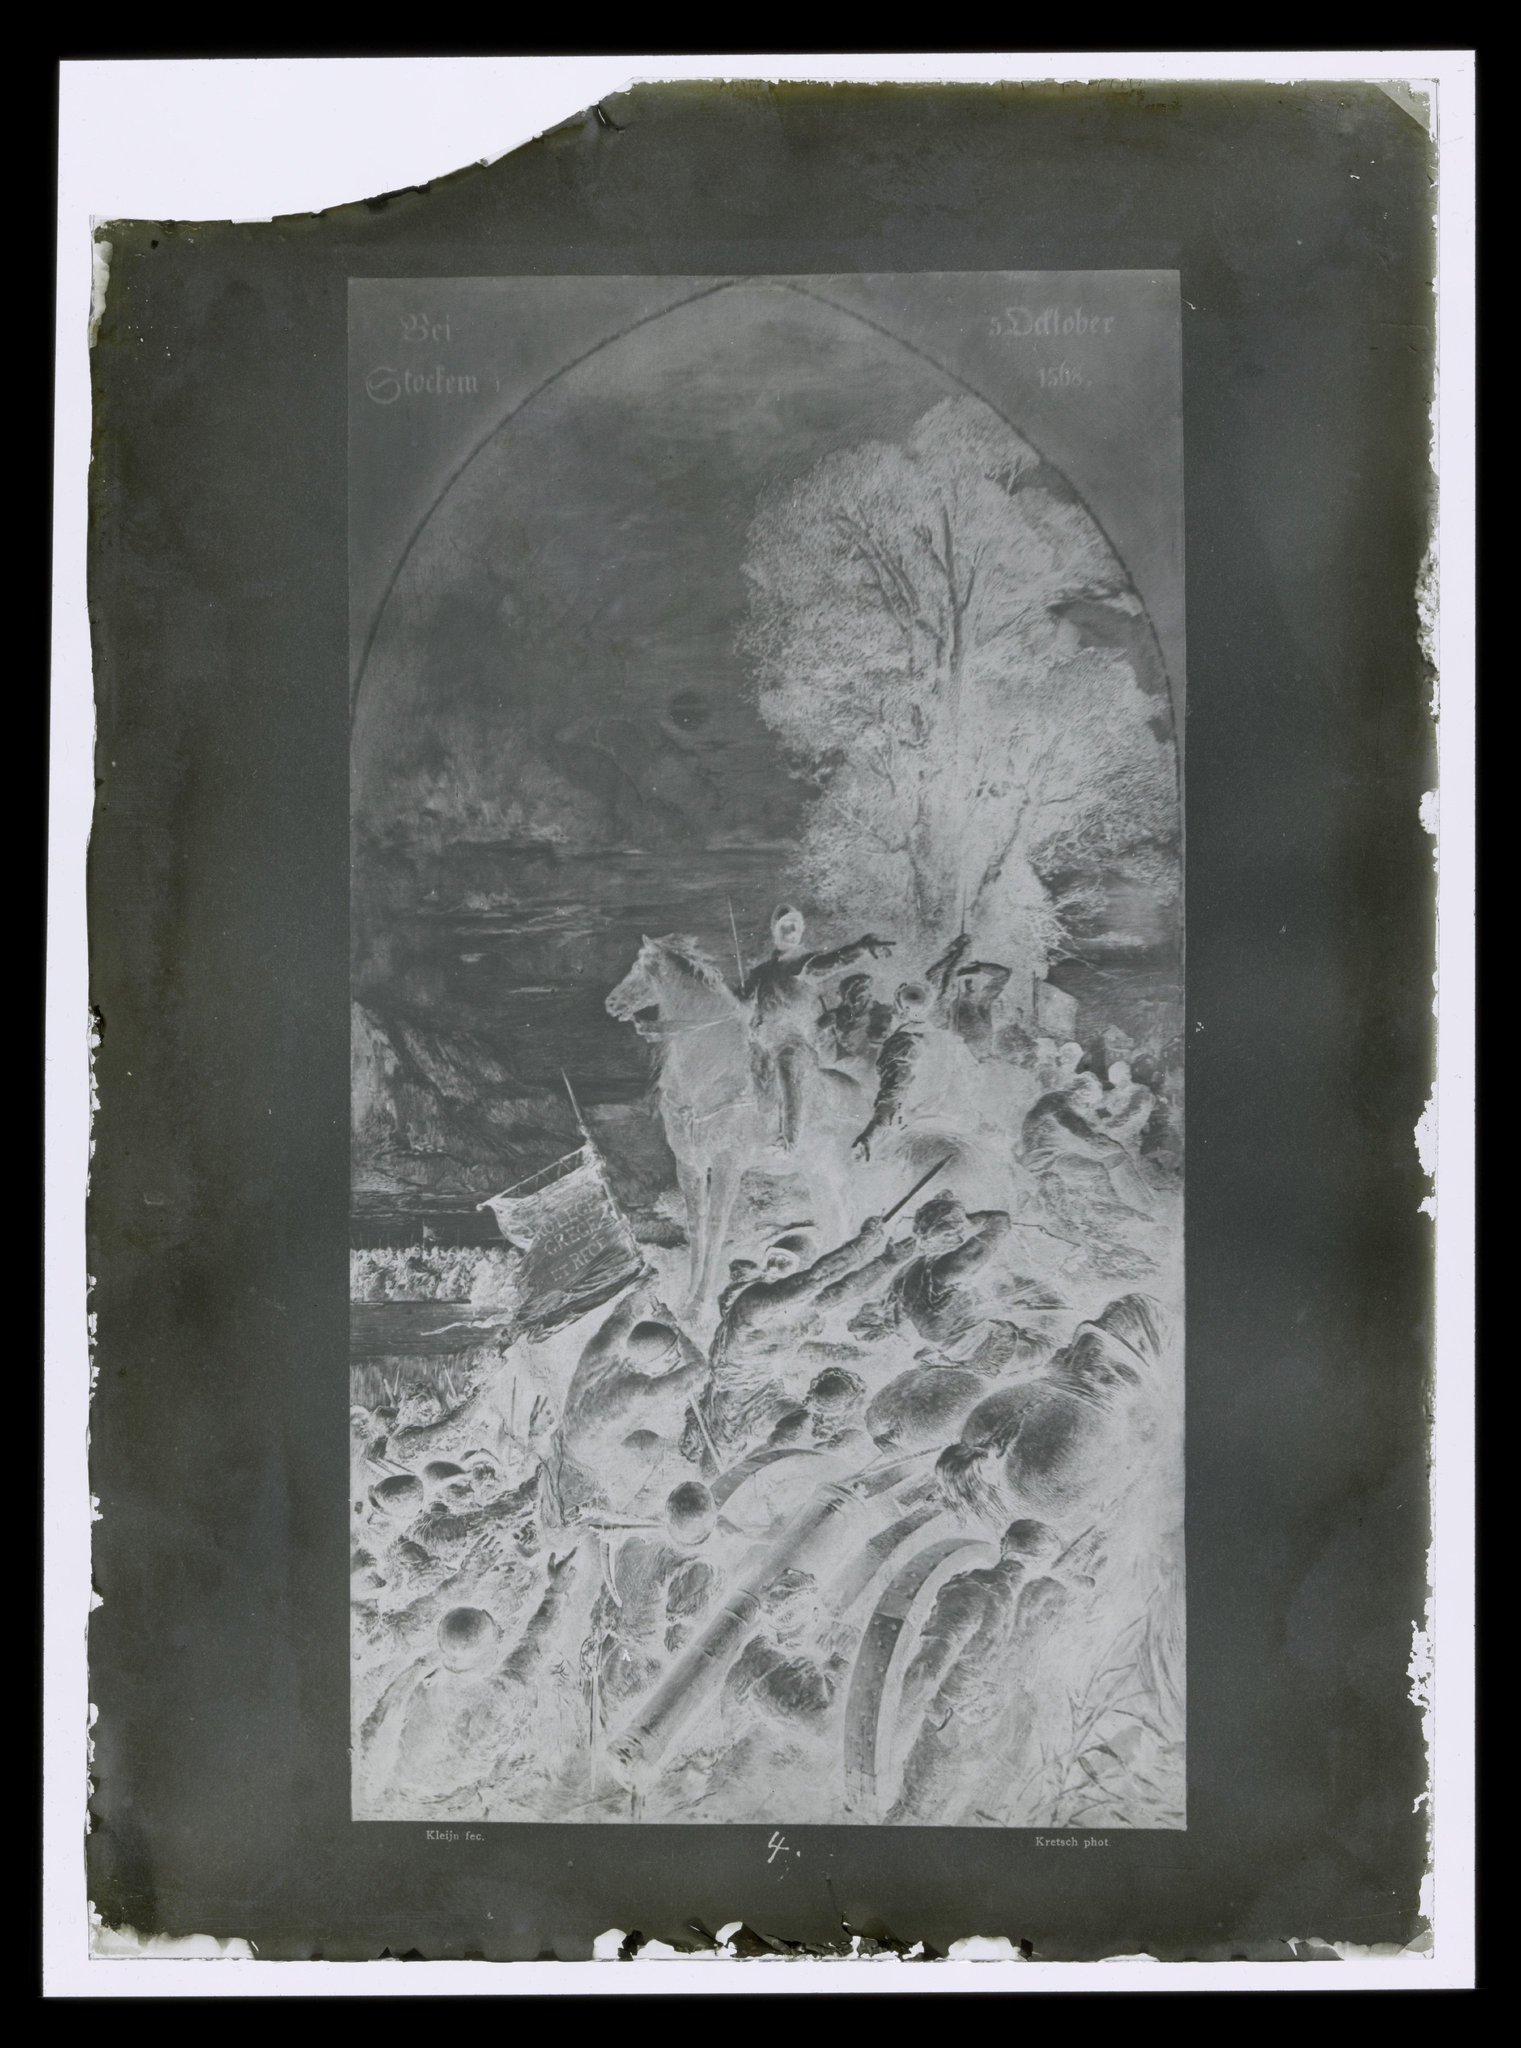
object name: reproduction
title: Fotoreproductie van een schilderij van de tocht van het leger van Willem van Oranje over de Maas bij Stokkem op 5 oktober 1568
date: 1865-1900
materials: glass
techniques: collodion process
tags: delft, william i (prince of orange), army 'en route'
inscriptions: number: ‘4.’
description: Onderdeel van een groep glasnegatieven uit de nalatenschap van de schilder Laurens Lodewijk Kleijn, met stillevens, portretten, zelfportretten en kunstreproducties.